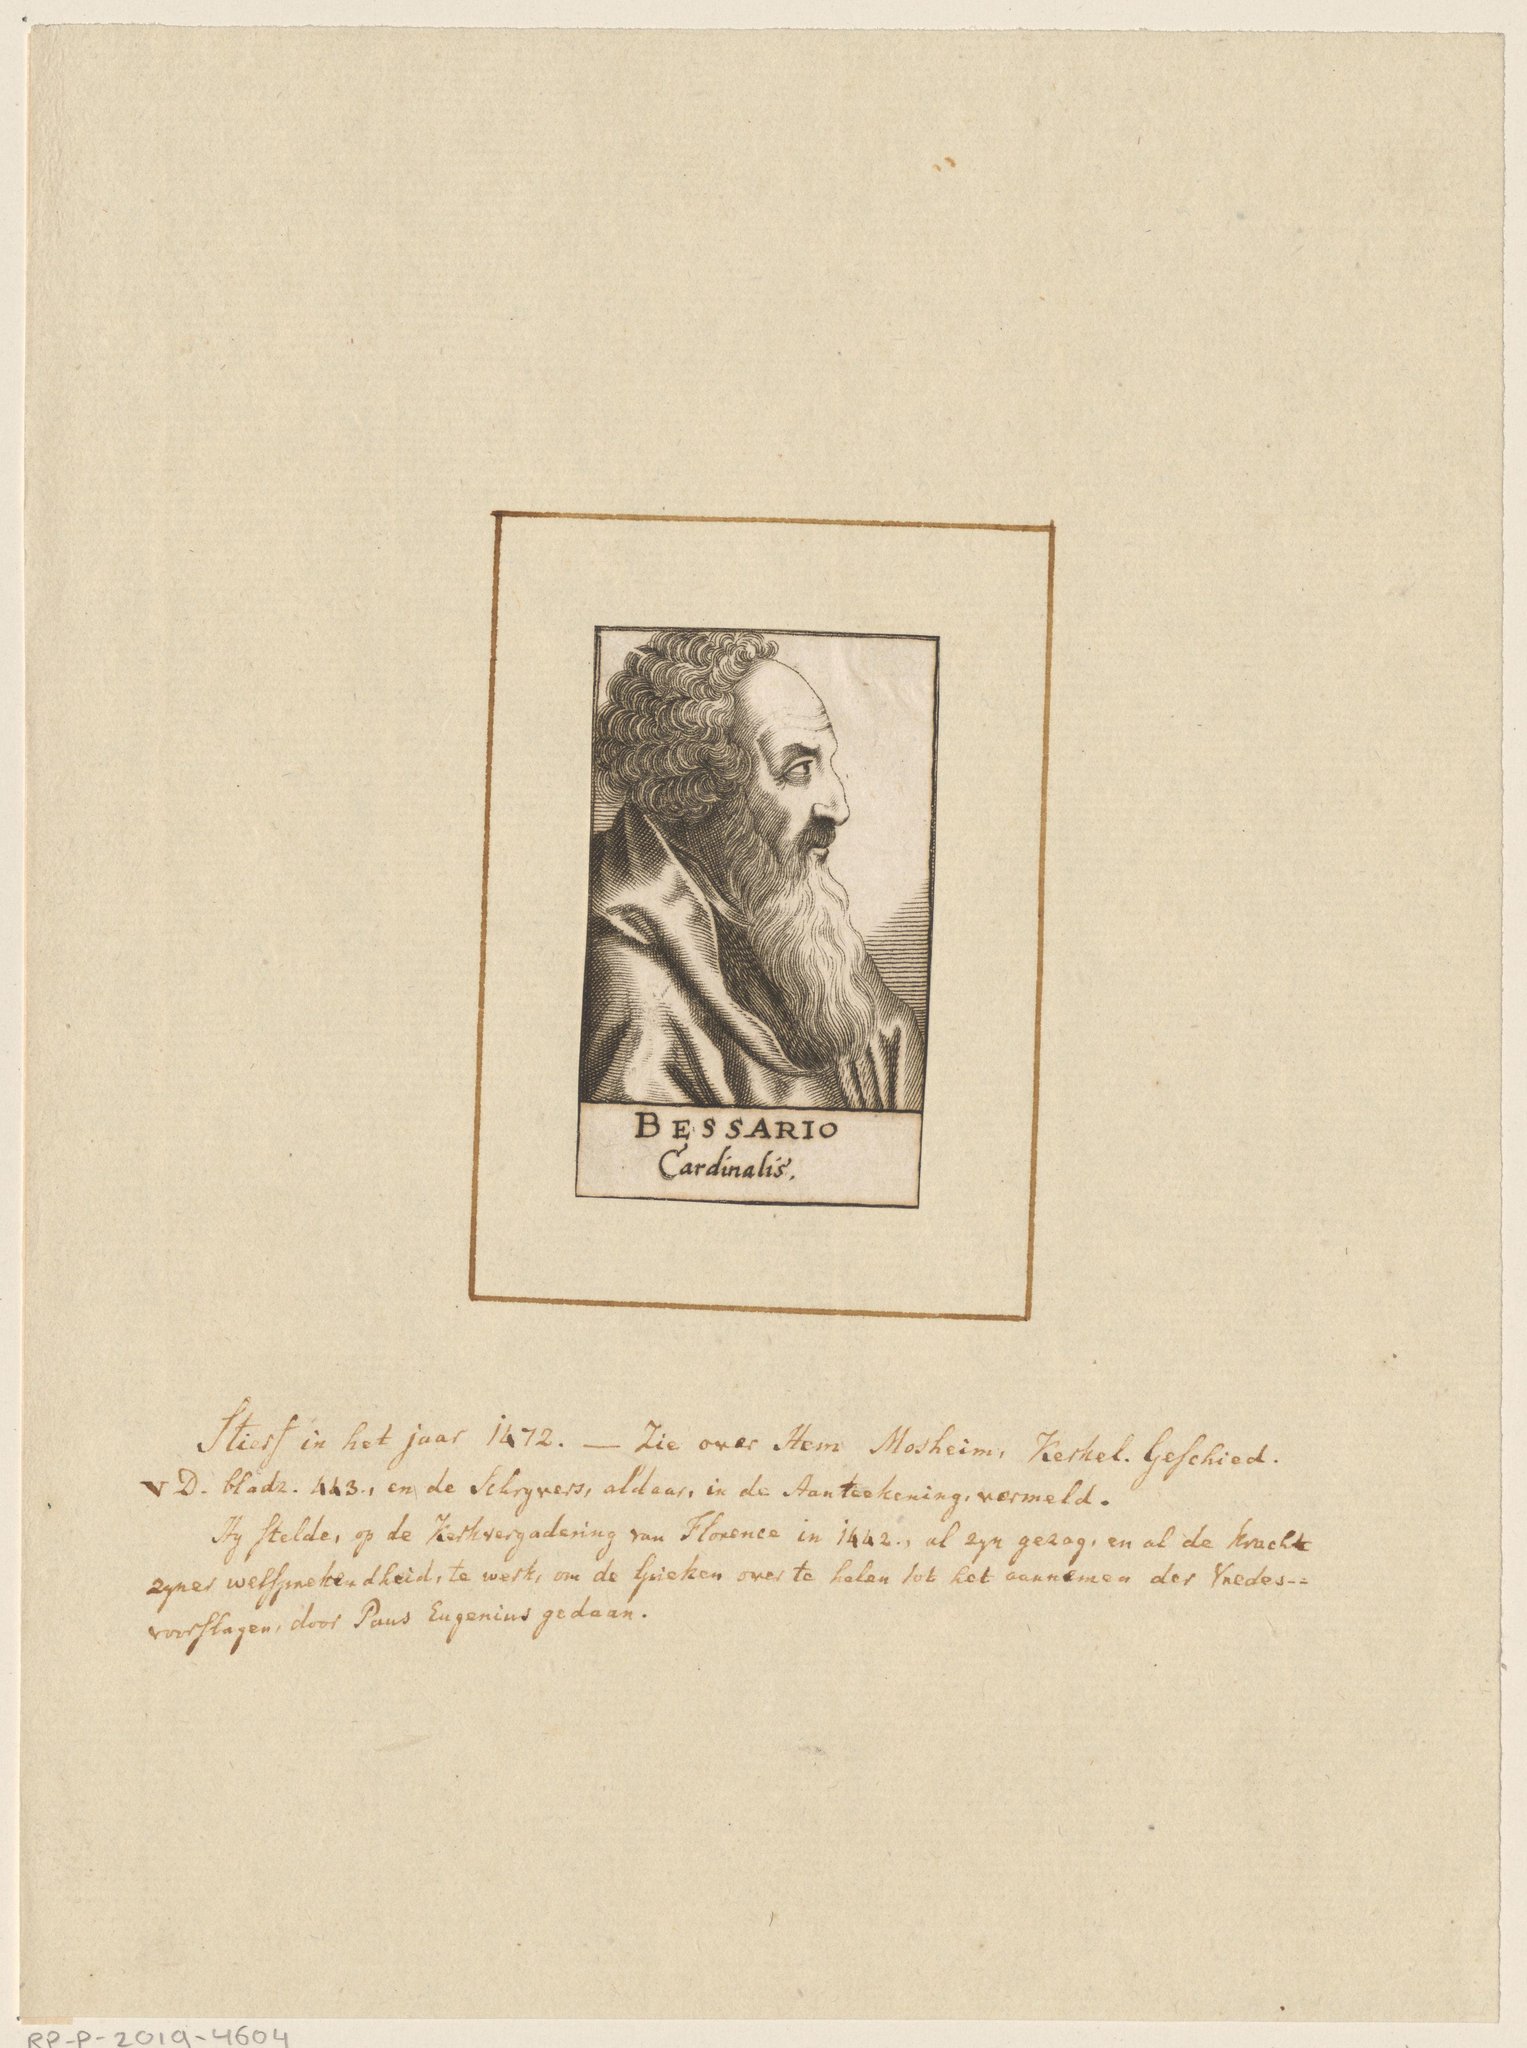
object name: print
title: Portret van Basilios Bessarion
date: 1688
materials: paper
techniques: engraving, etching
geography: nuremberg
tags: theologian, historical persons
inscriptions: inscription: ‘Stierf in het jaar 1472 [...]’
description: Prent uit: Freher, Paul. Theatrum virorum eruditione clarorum. Neurenberg: Johann Hoffmann, 1688.